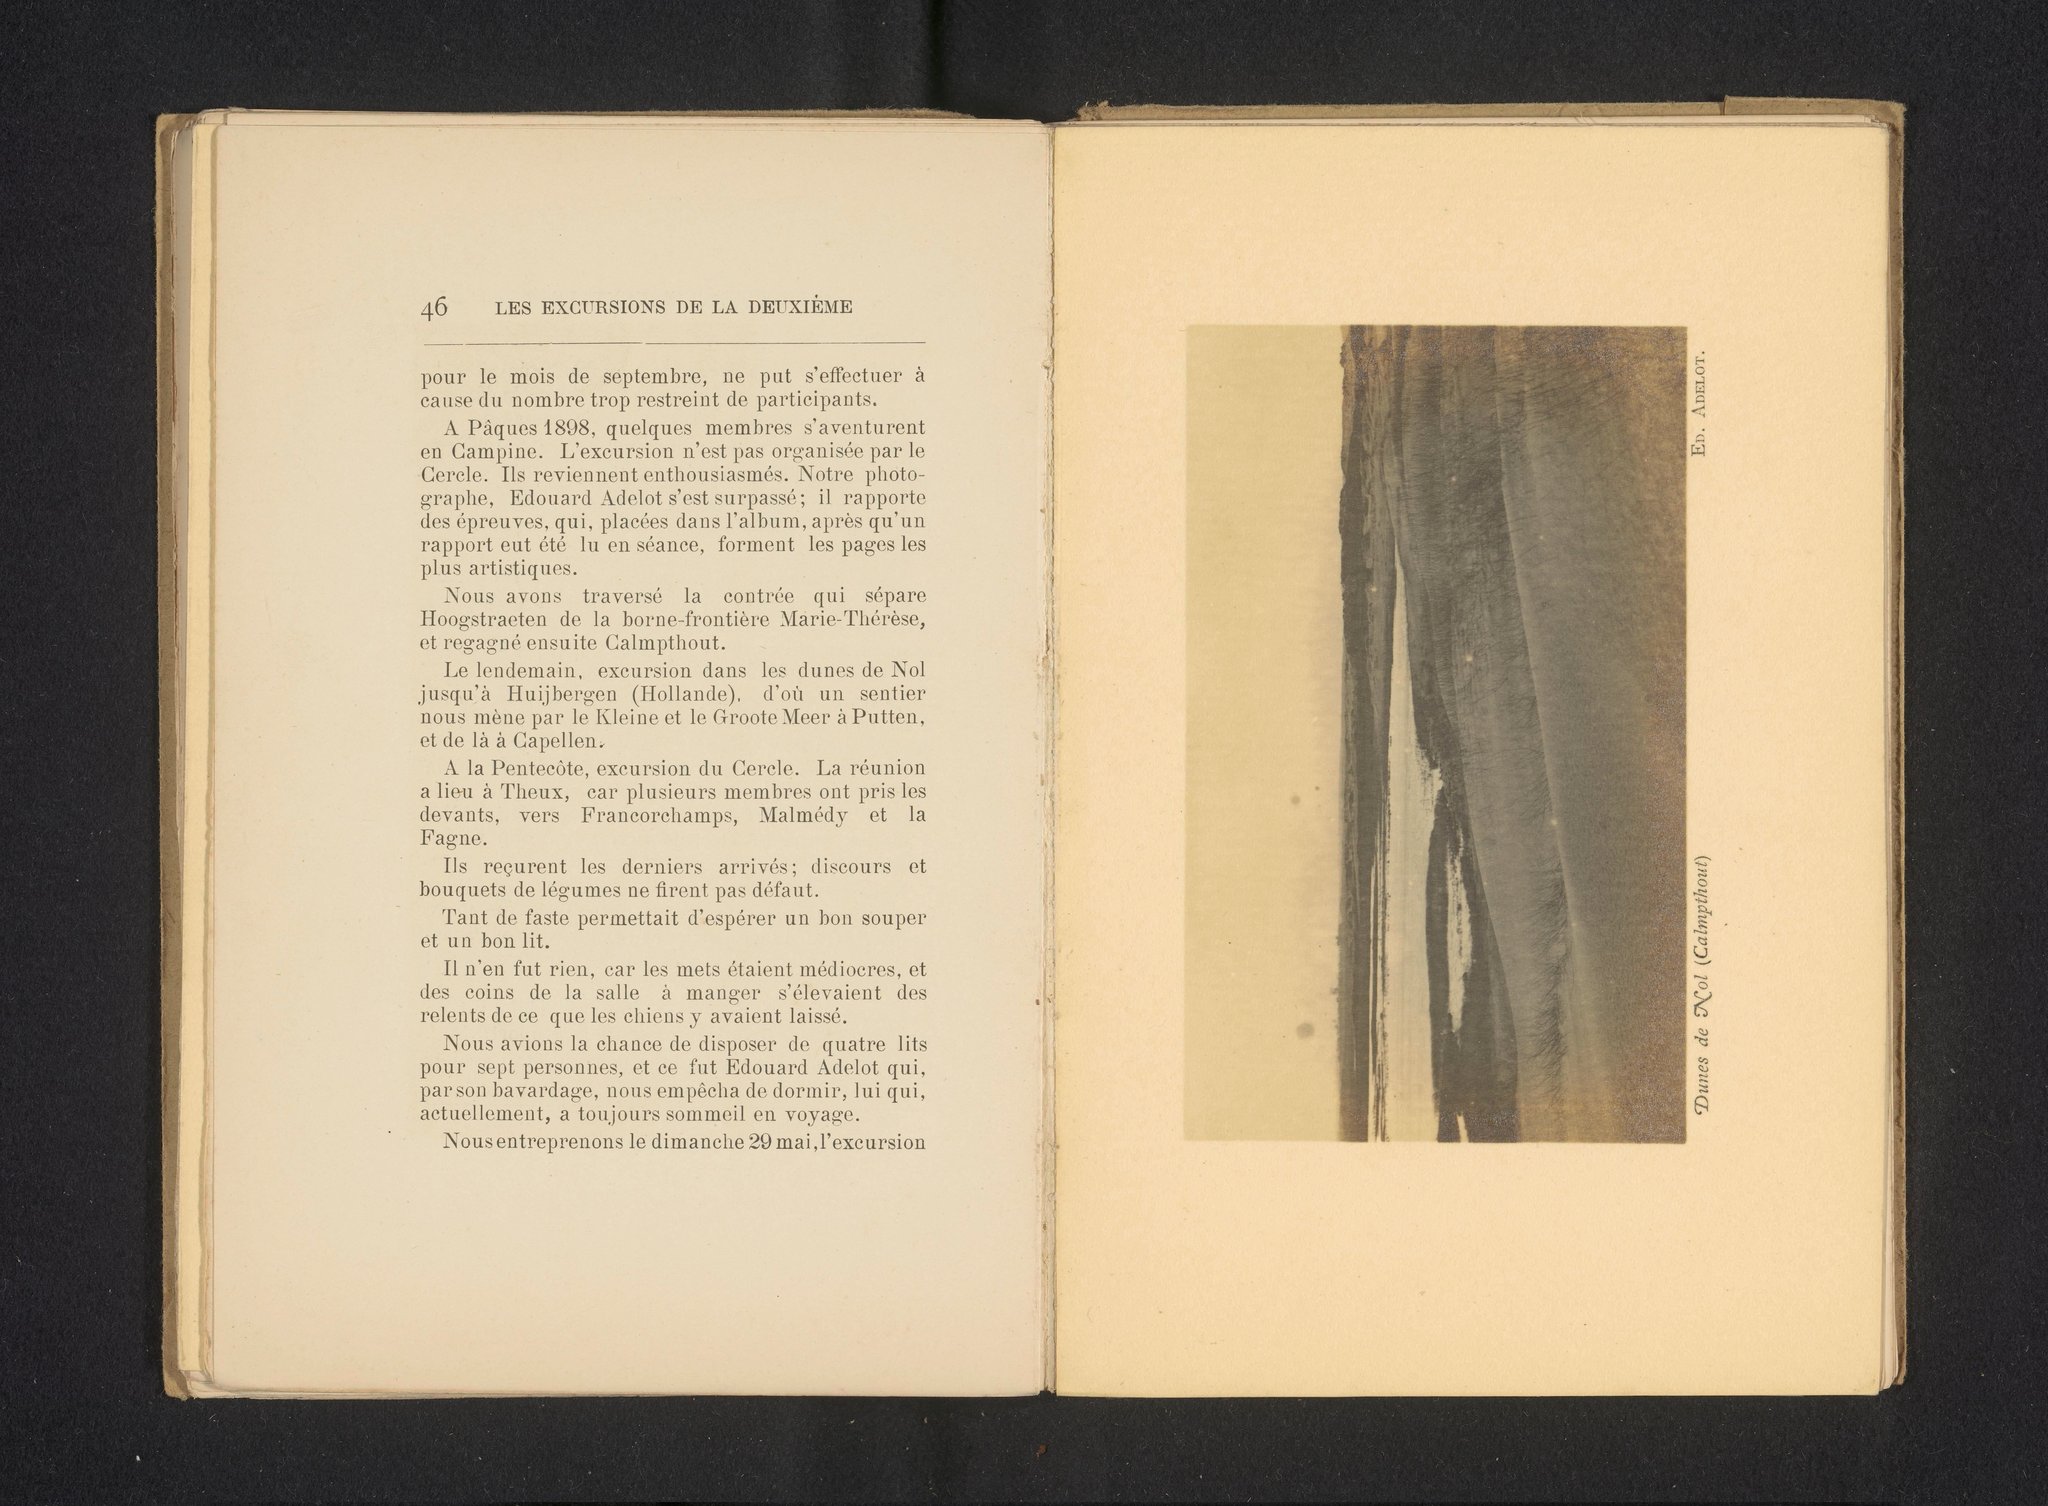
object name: page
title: Dunes de Nol (Calmpthout)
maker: edouard adelot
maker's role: fotograaf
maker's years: 1871-1937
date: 1896-1901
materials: photographic support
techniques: gelatin silver print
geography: kalmthout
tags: landscapes